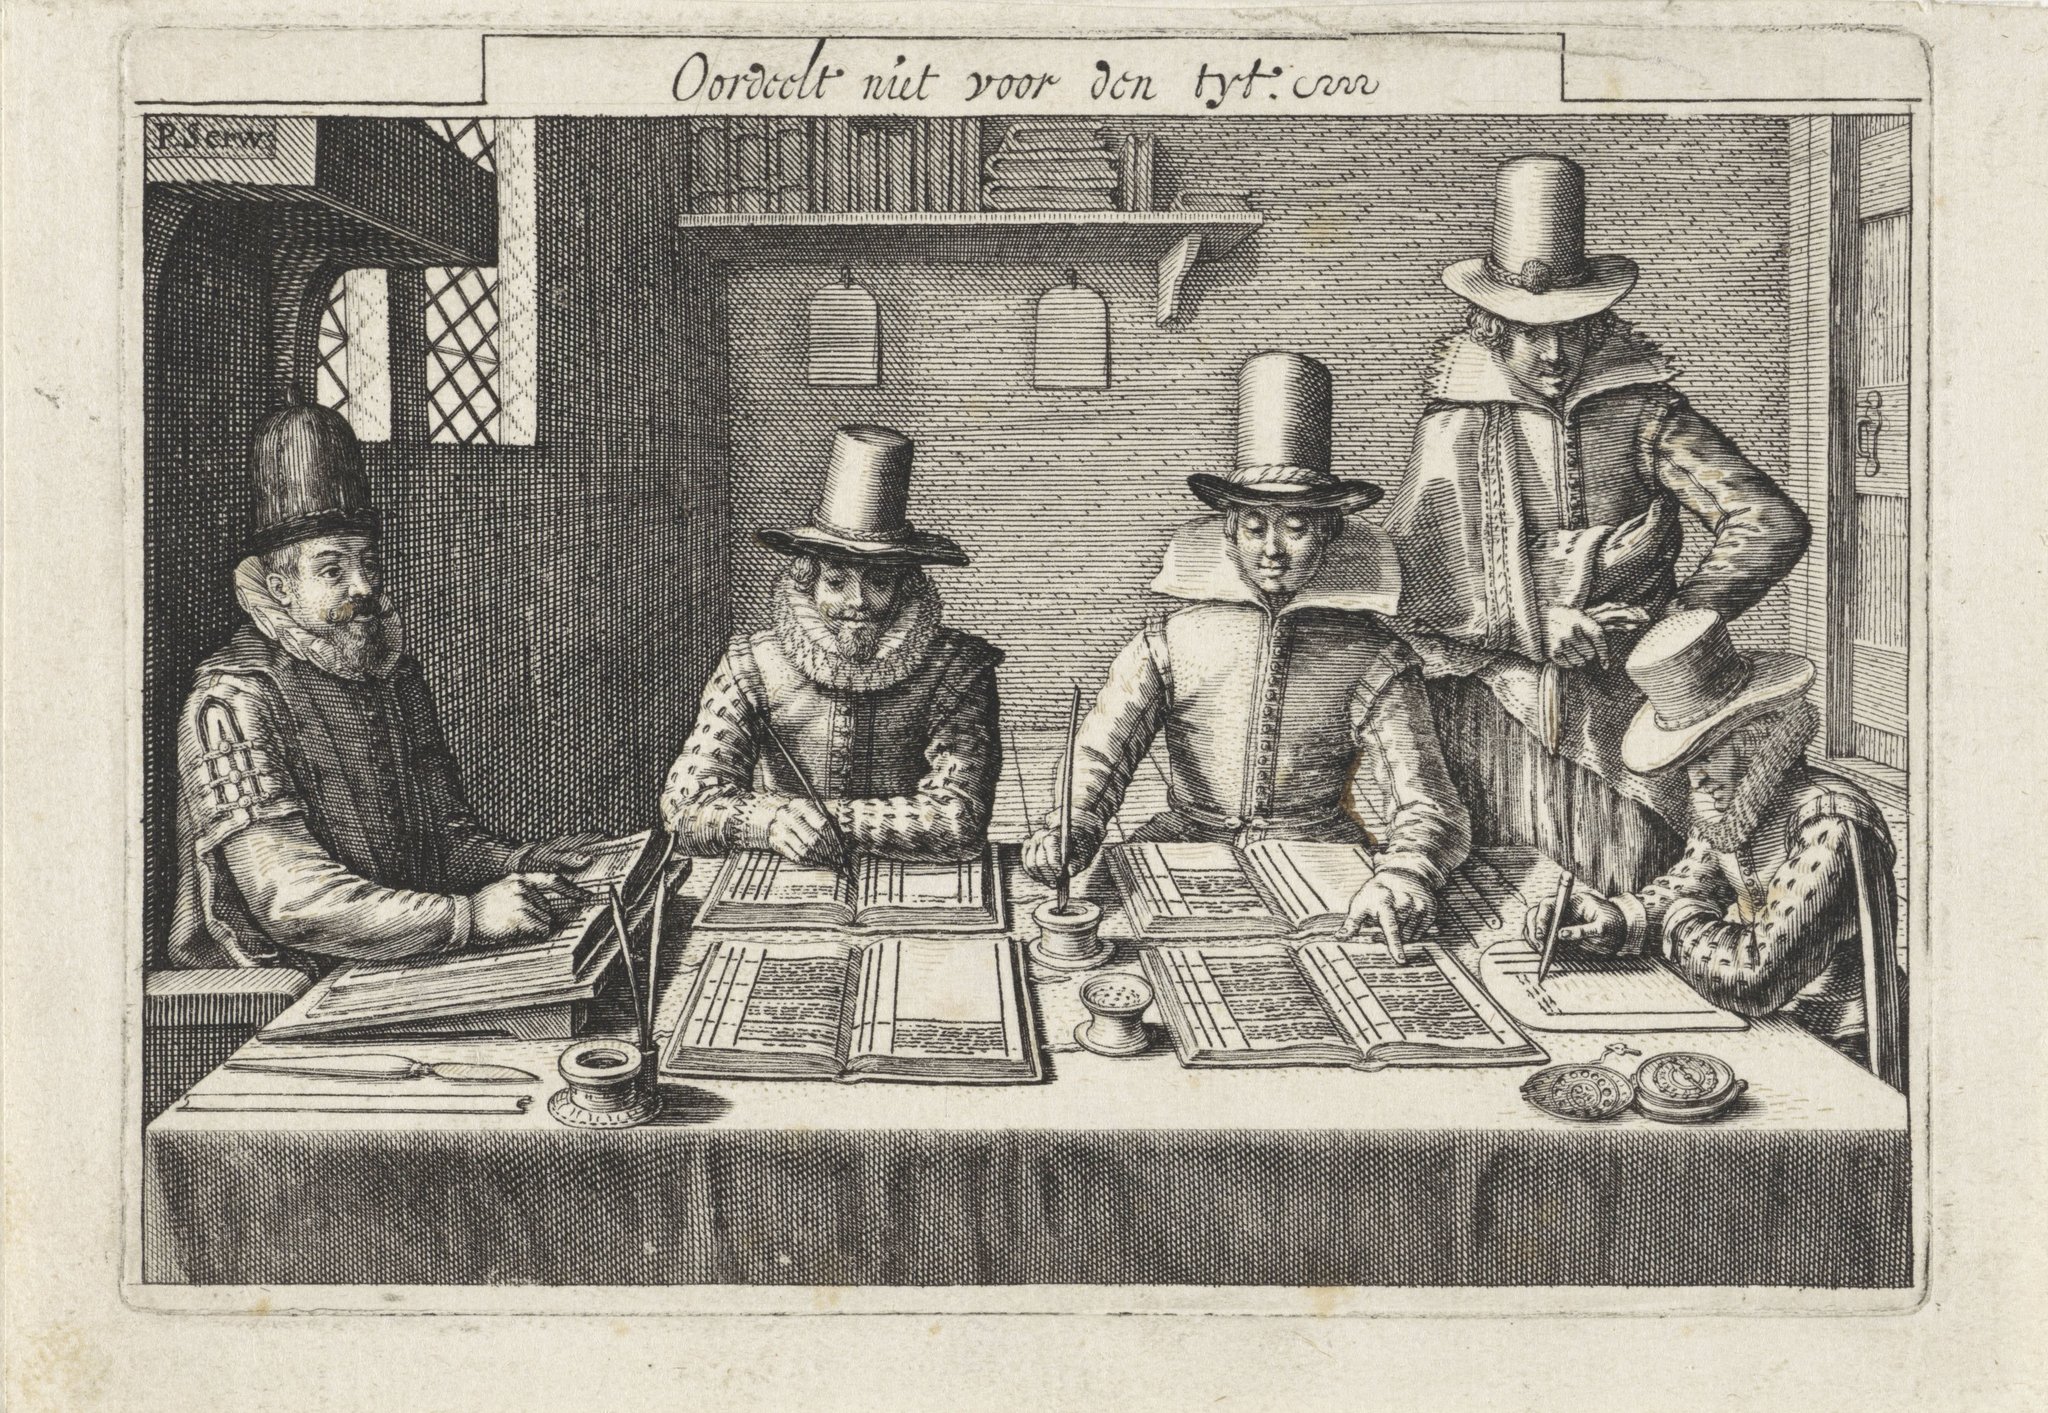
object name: print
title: Boekhouders aan het werk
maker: pieter serwouters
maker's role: draughtsman, print maker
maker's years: 1586-1657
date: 1601-1657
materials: paper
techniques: engraving, etching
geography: amsterdam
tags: writing tablets, bookshelves, book, book-keeping, accountant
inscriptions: collector's mark: Lugt 2228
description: Rekenschool waarin het boekhouden wordt onderwezen. Aan een tafel zit links, in een stoel met baldakijn, de rekenmeester. Drie leerlingen zitten met rekenboeken voor zich te schrijven. Een vierde staat ter rechterzijde bij de tafel toe te kijken. Tegen de achterwand van het vertrek een boekenplank en twee schrijftabletten. Daar boven de zinspreuk "Oordeelt niet voor den tyt". Boven de afbeelding de titel van het boek, de naam van de auteur en een korte inhoudsweergave. Onder de prent het impressum.